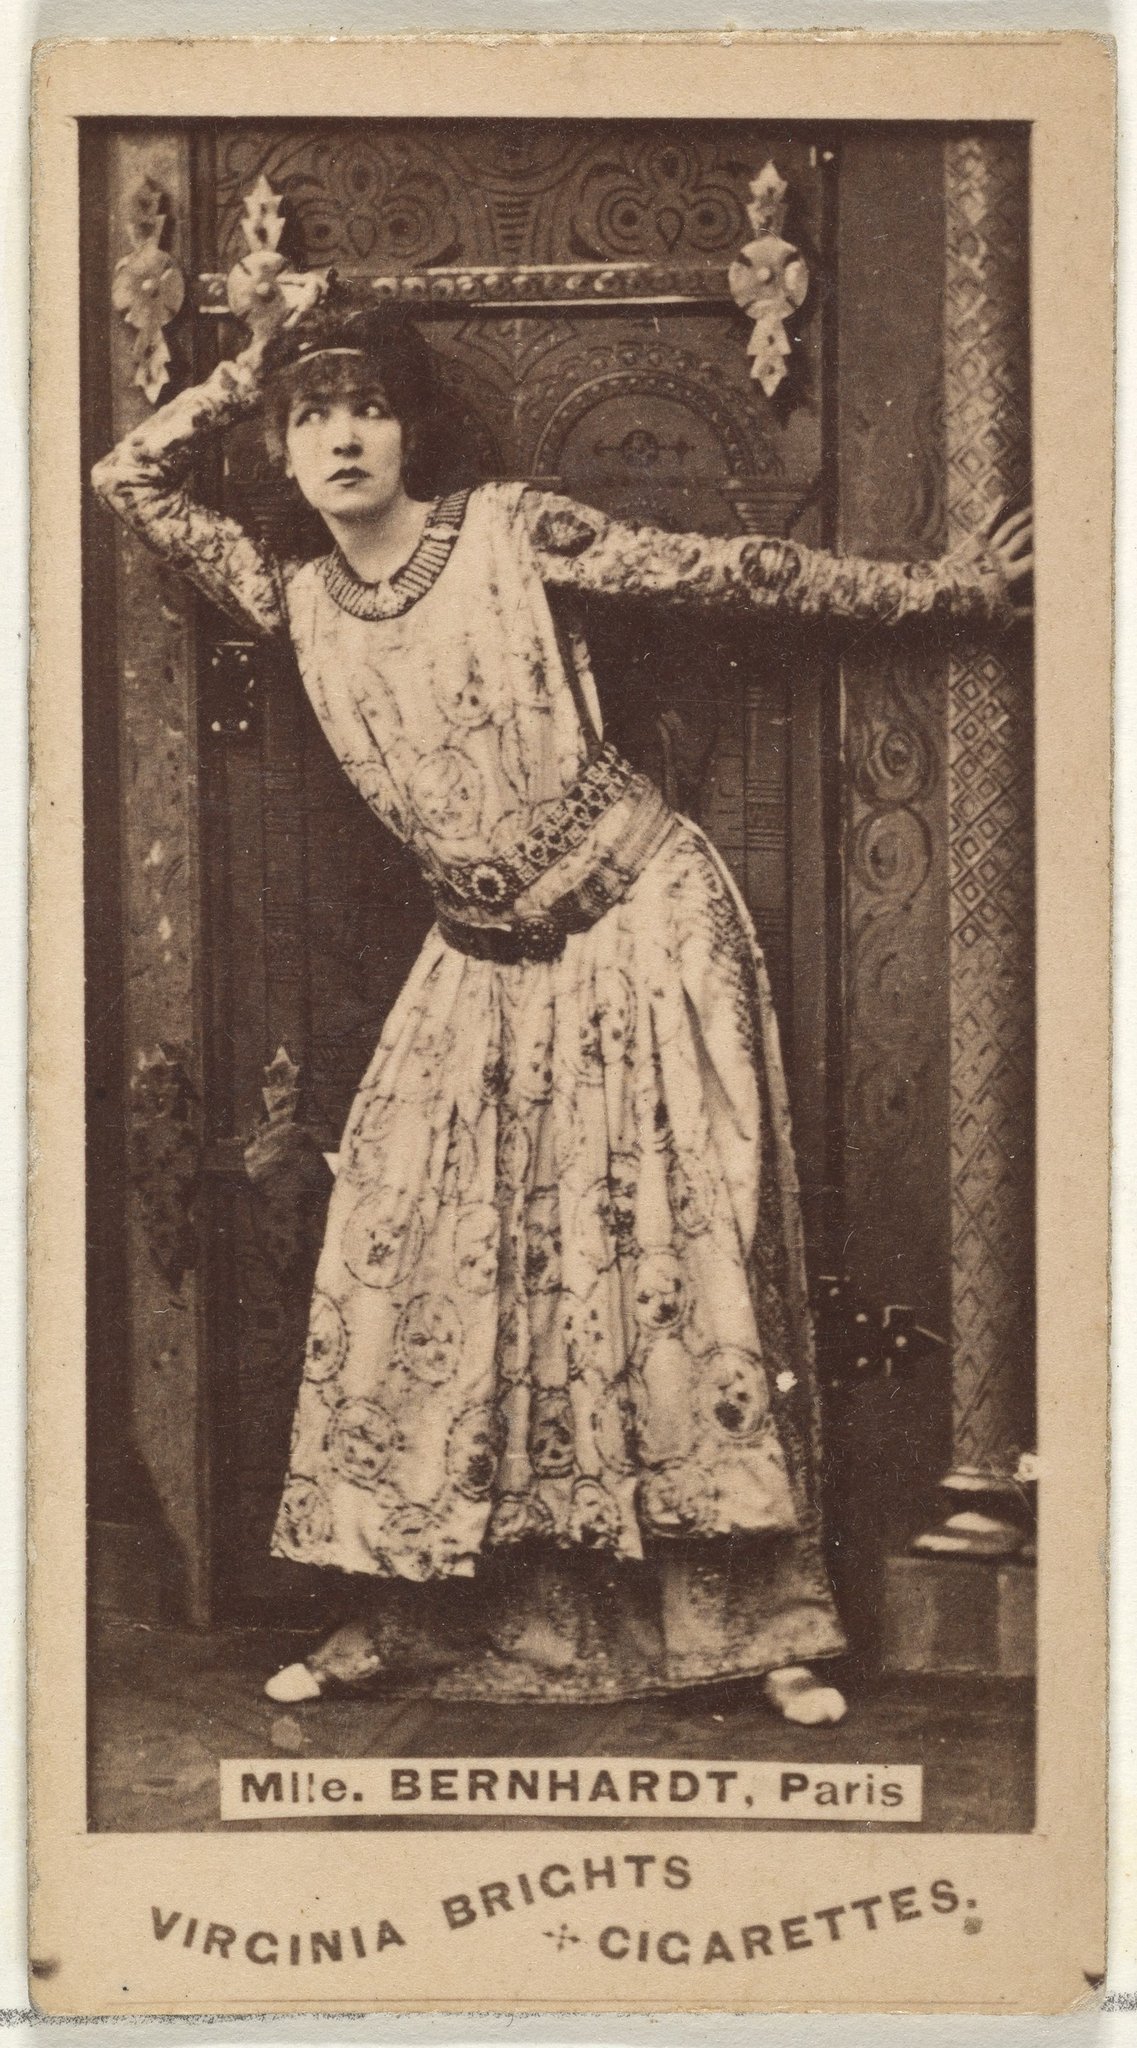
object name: photograph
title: Mlle. Bernhardt, Paris, from the Actors and Actresses series (N45, Type 1) for Virginia Brights Cigarettes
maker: allen & ginter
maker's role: publisher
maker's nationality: american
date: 1888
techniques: albumen silver print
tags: portraits,women,actresses